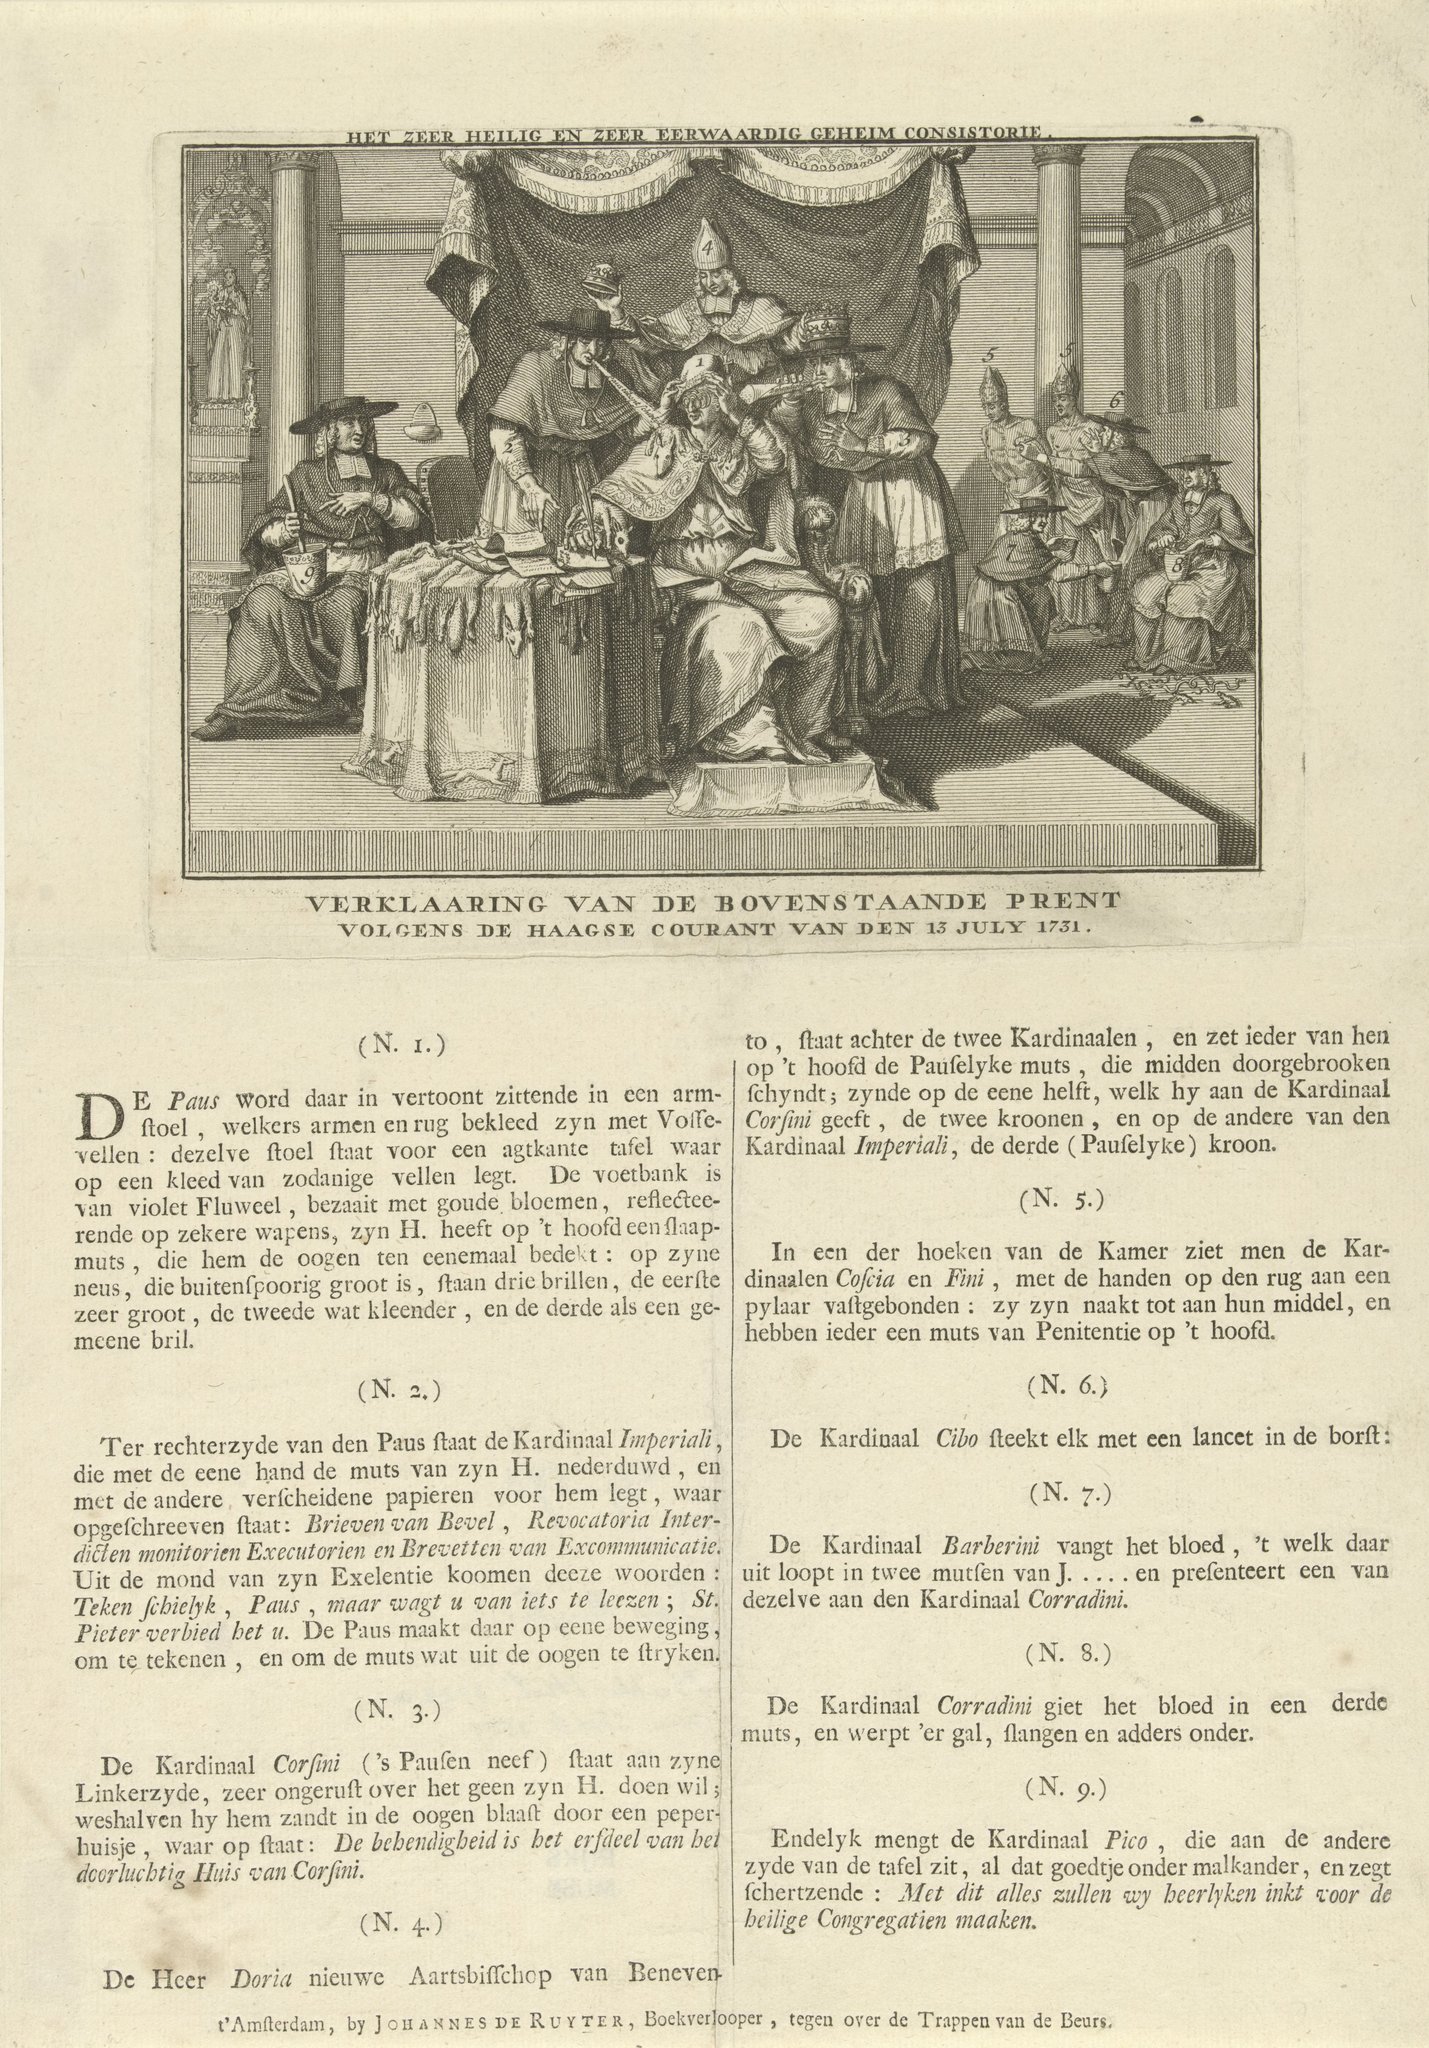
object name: print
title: Spotprent op de paus en kardinalen, 1731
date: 1731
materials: paper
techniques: etching, letterpress printing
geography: amsterdam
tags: rome, clemens xii, eyeglasses, spectacles, (aspects of) christian religion or the church (as institution) ridiculed, criticized, or caricaturized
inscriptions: collector's mark: Lugt 2166, collector's mark: Lugt 2760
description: Spotprent op de paus en kardinalen, in verband met het verzet tegen de bezetting van Parma door Oostenrijk, na de dood van de hertog van Parma, juni 1731. De slechtziende paus (met drie brillen) wil een document ondertekenen maar wordt door kardinalen zand in de ogen geblazen. Op het blad onder de plaat de verklaring van de de cijfers 1-9 in het Nederlands, volgens de Haagse Courant van 13 juli 1731.